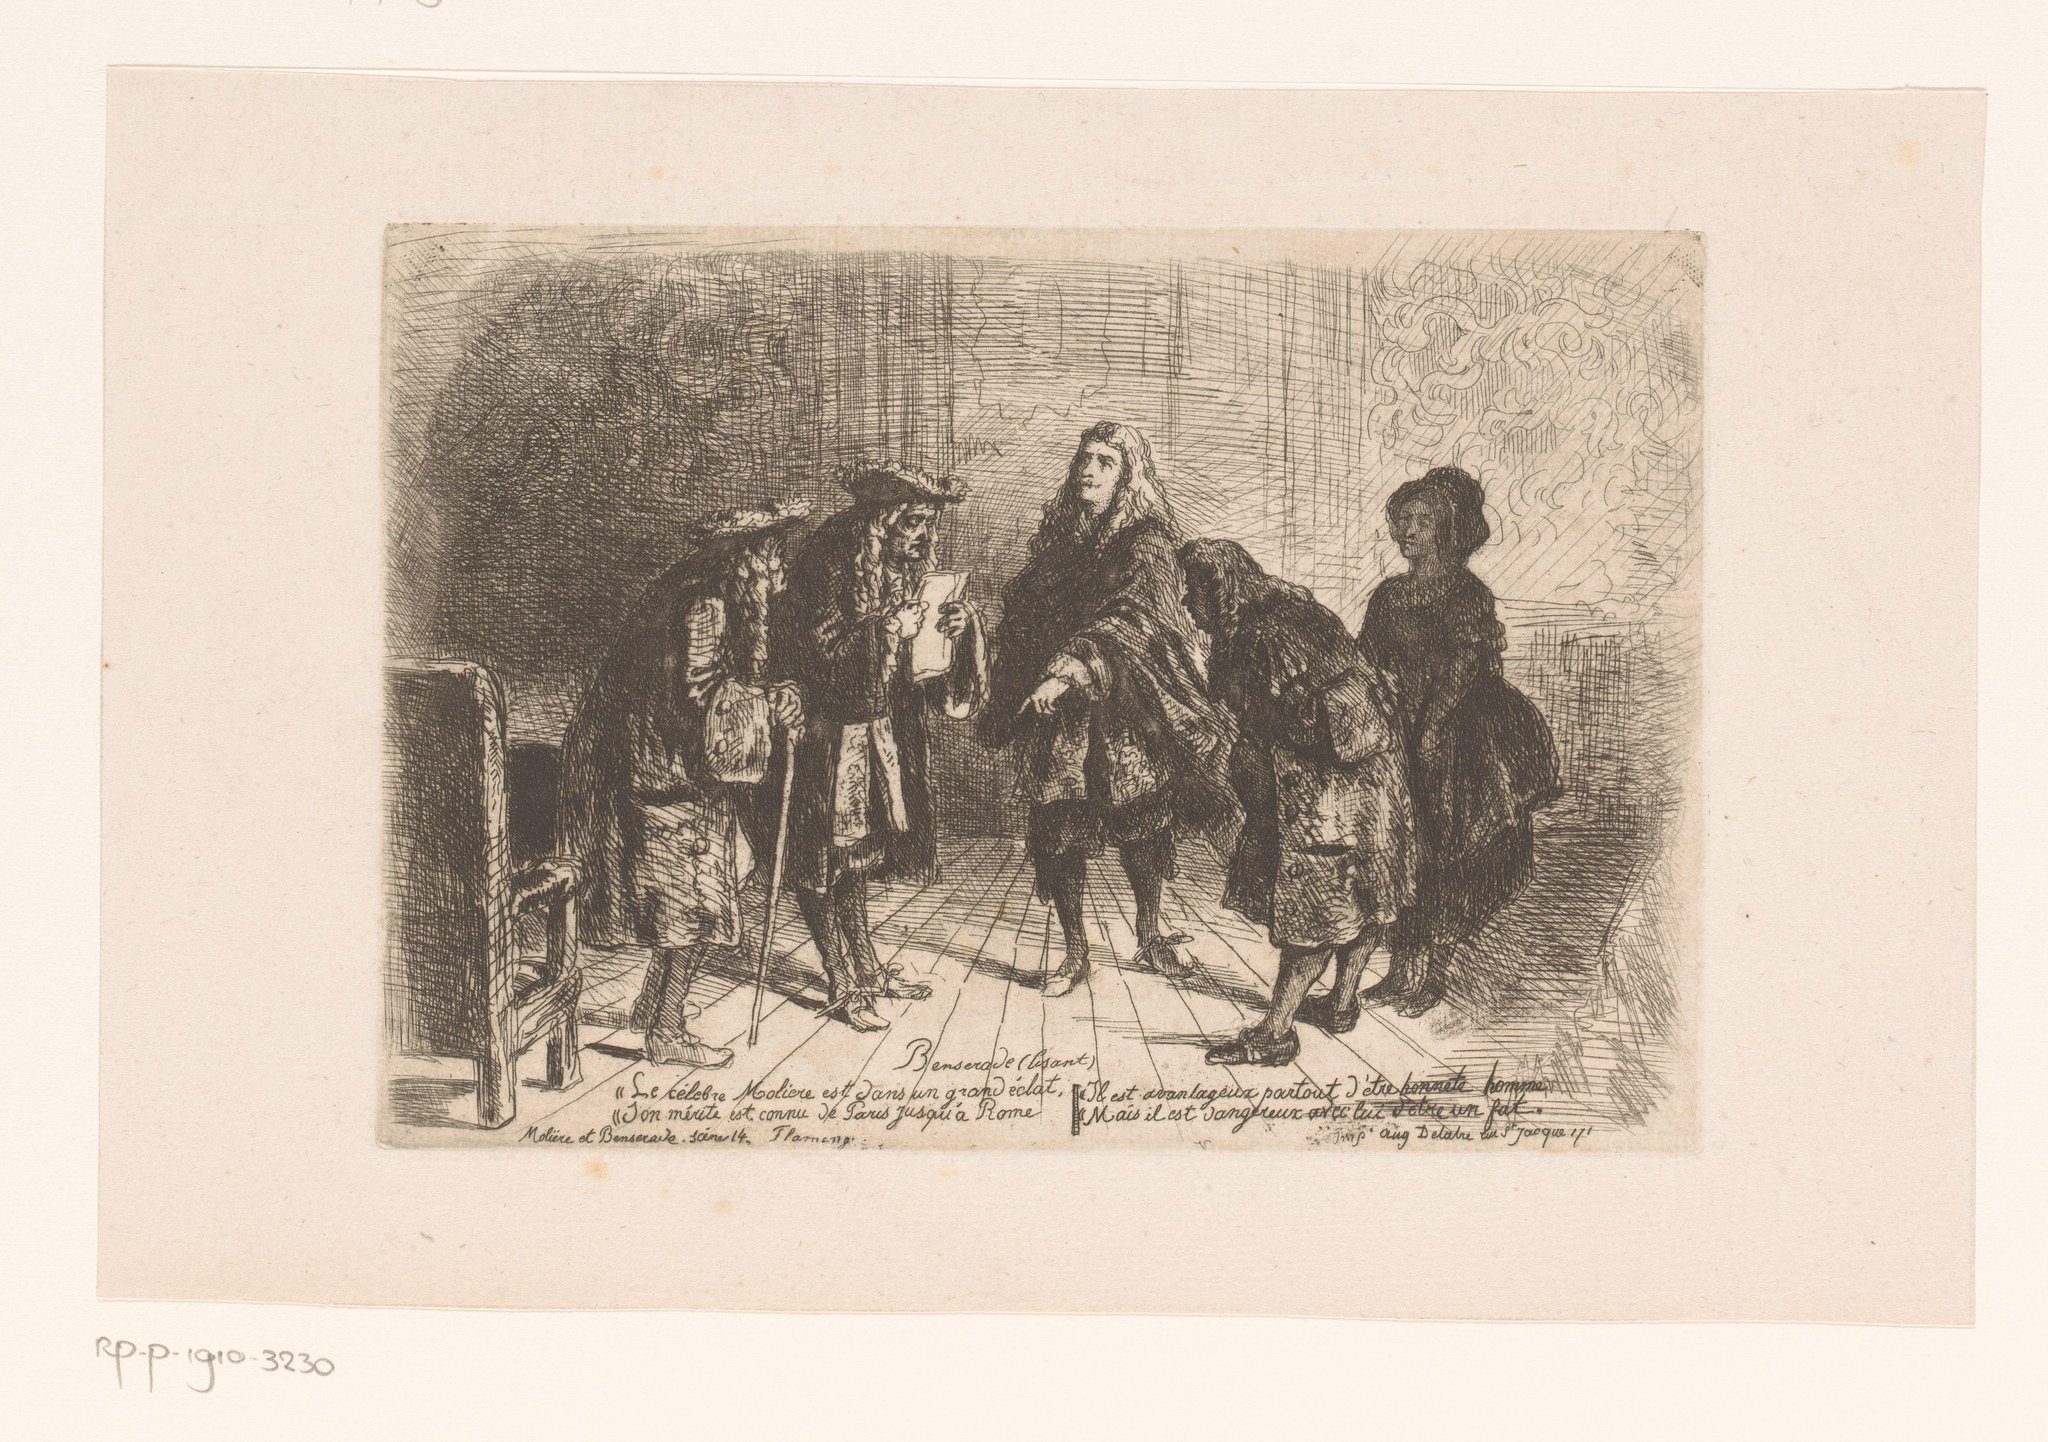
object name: print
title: Benserade leest een brief voor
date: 1841-1910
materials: paper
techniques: drypoint, etching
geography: paris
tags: reading to somebody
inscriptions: collector's mark: Lugt 2228